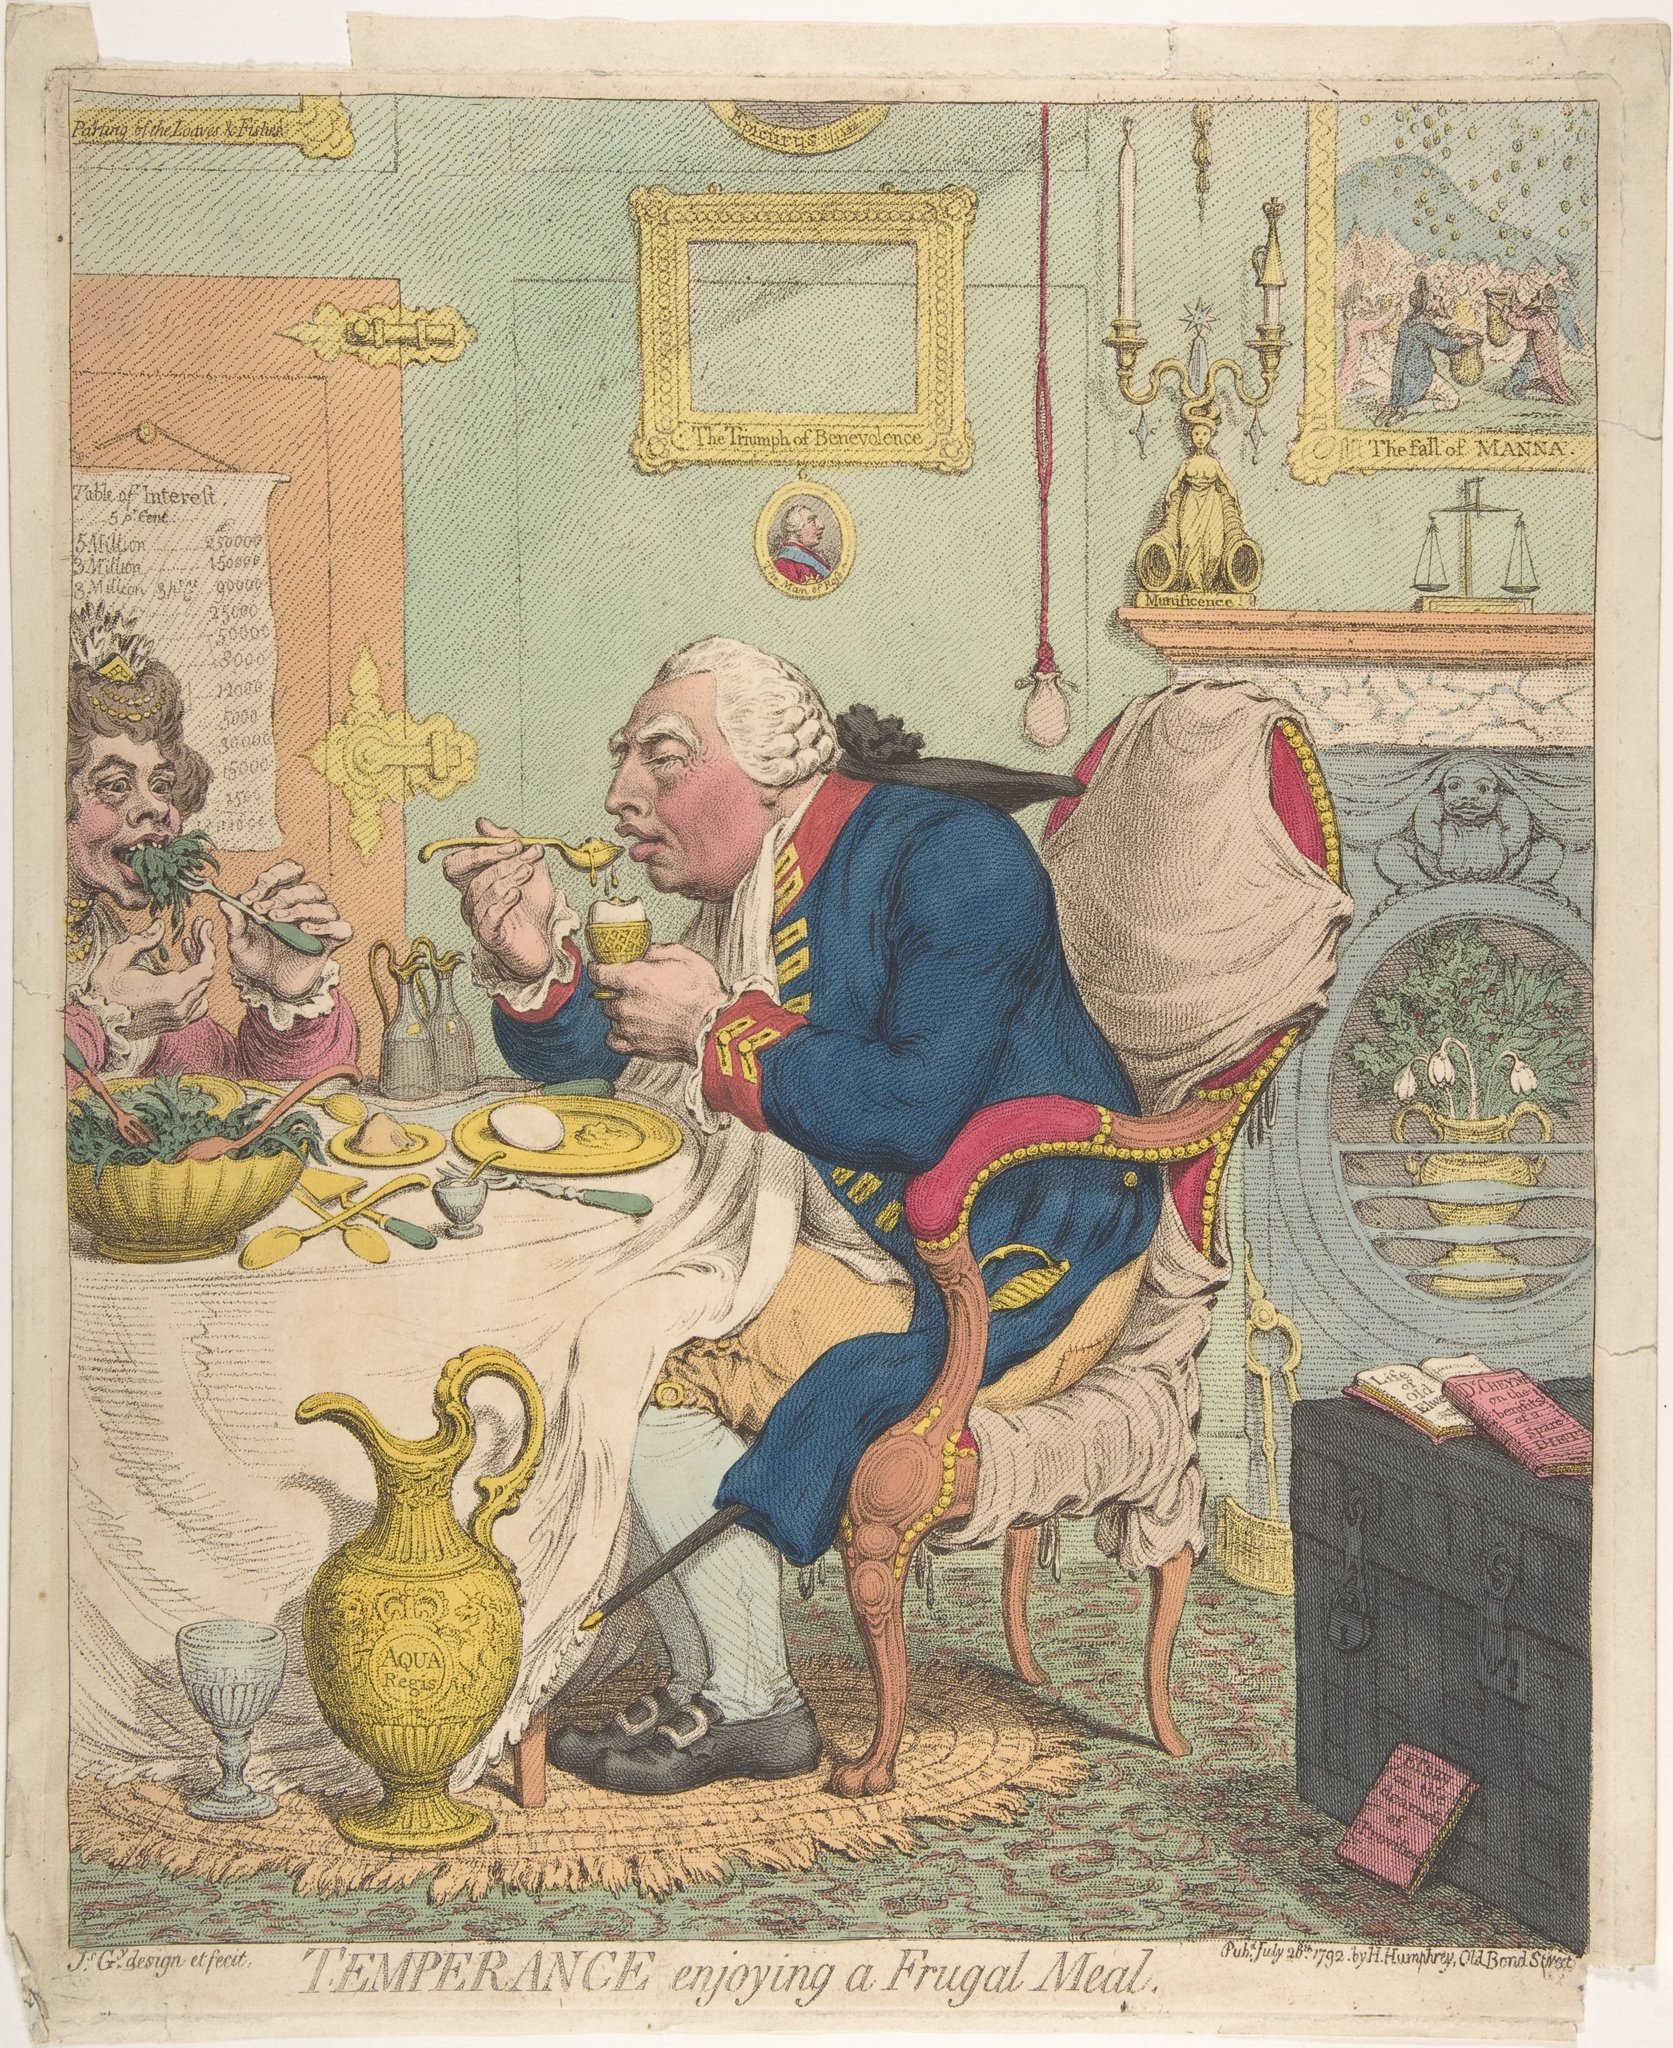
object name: print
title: Temperance Enjoying a Frugal Meal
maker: james gillray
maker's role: artist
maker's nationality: british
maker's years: 1756-1815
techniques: etching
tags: food,satire,men,women,dining